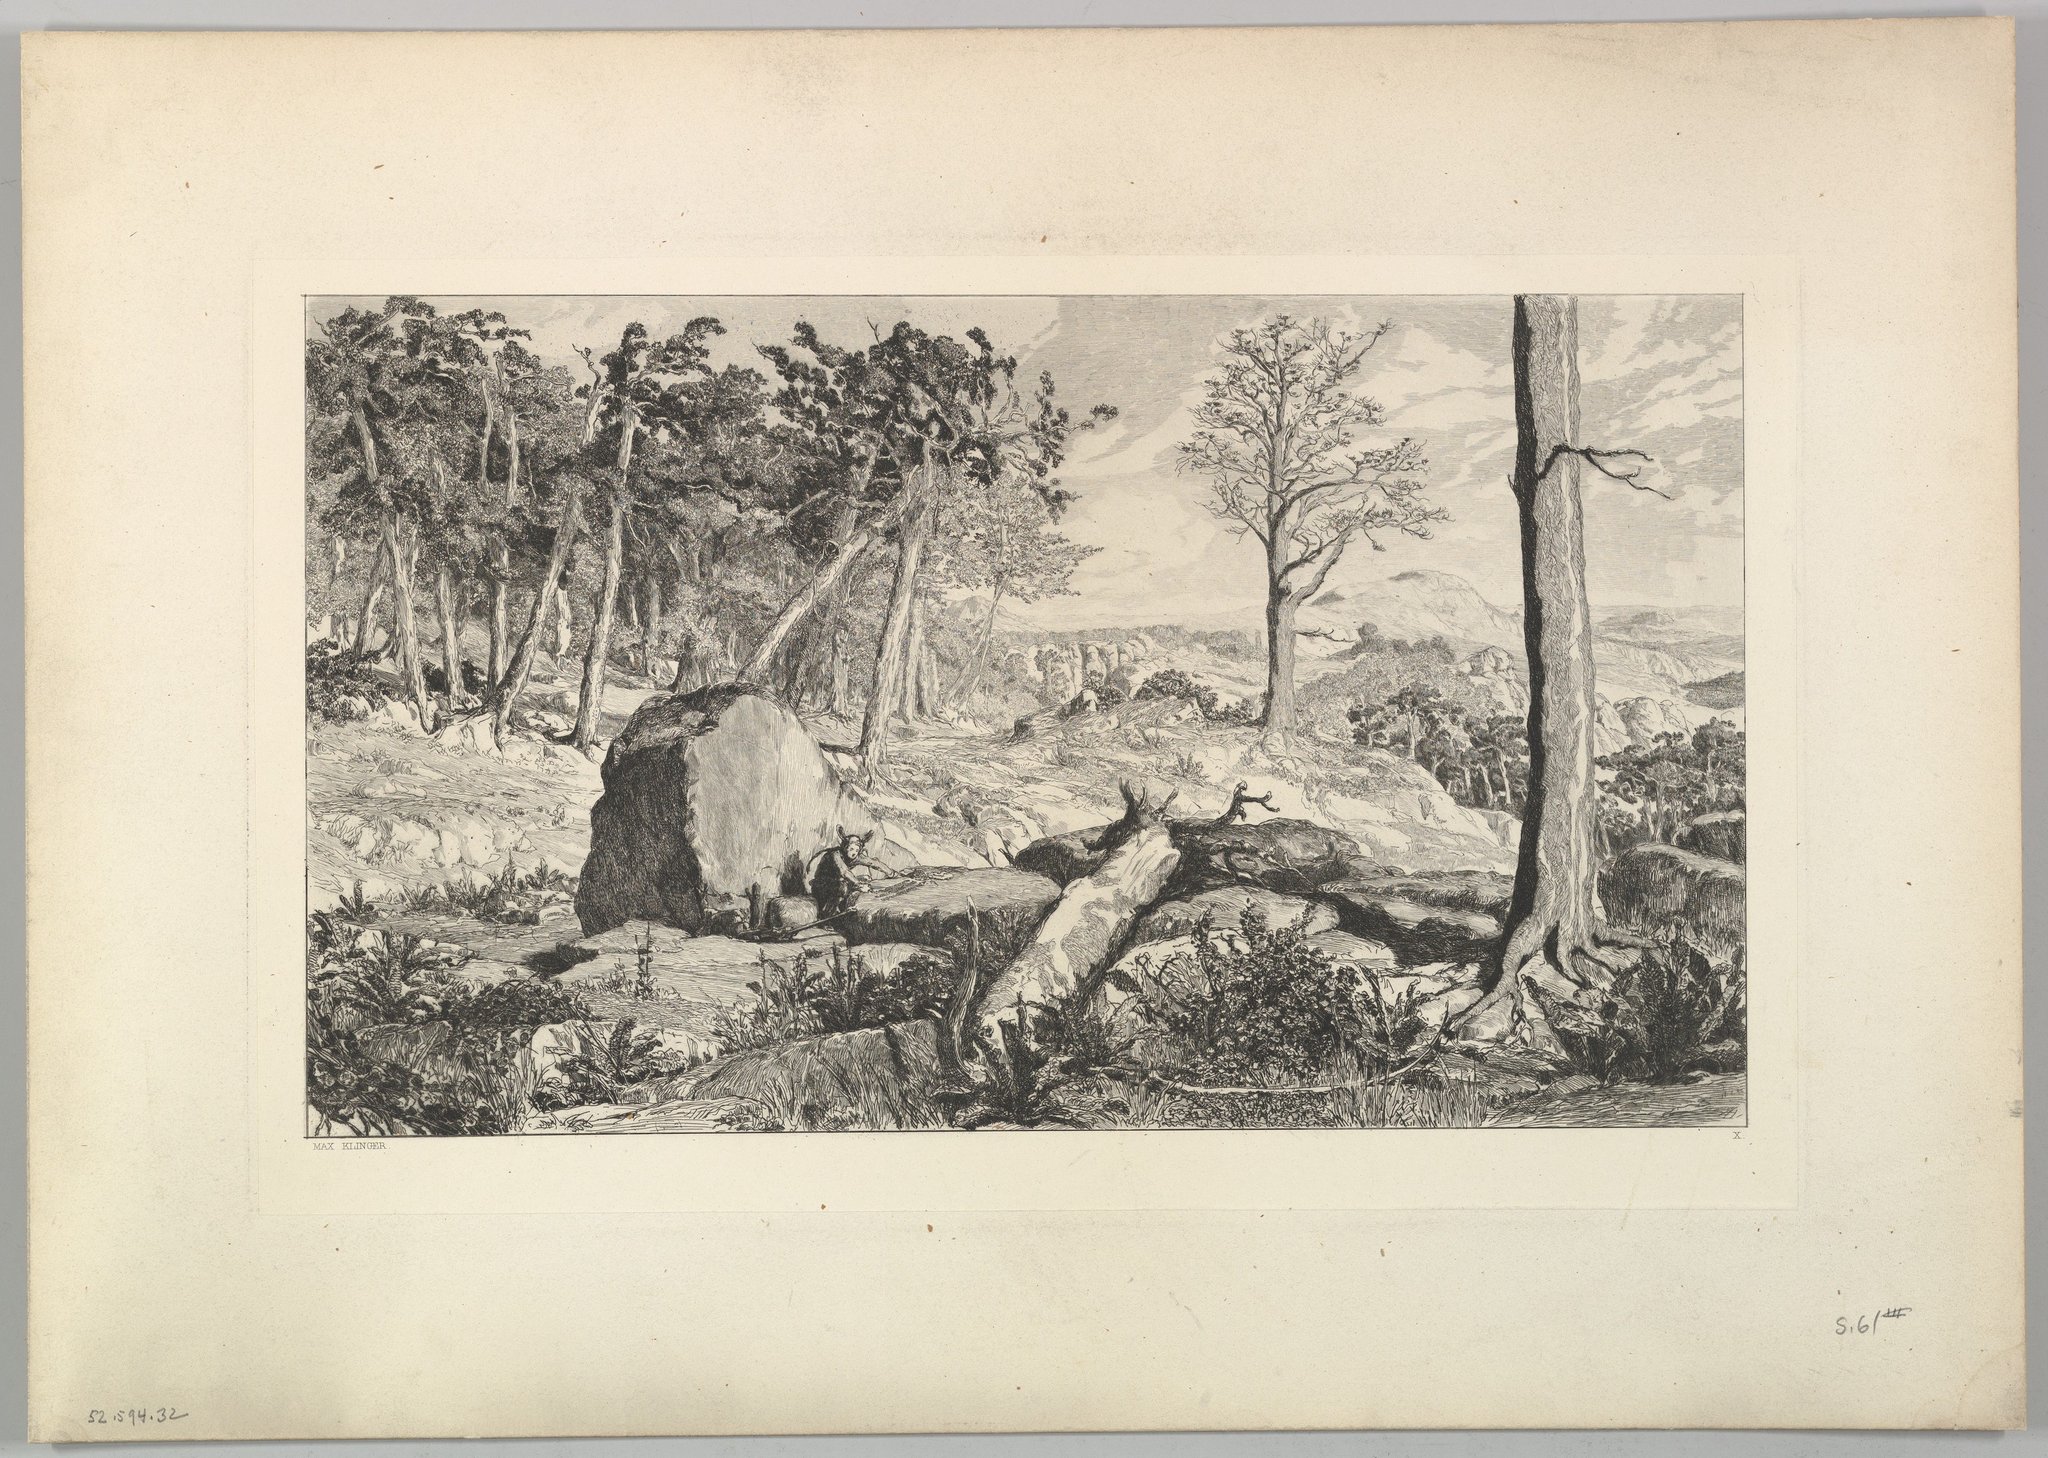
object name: print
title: Simplicius in der Waldeinöde, from the series Intermezzi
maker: max klinger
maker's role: artist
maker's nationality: german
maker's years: 1857-1920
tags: animals,landscapes,trees